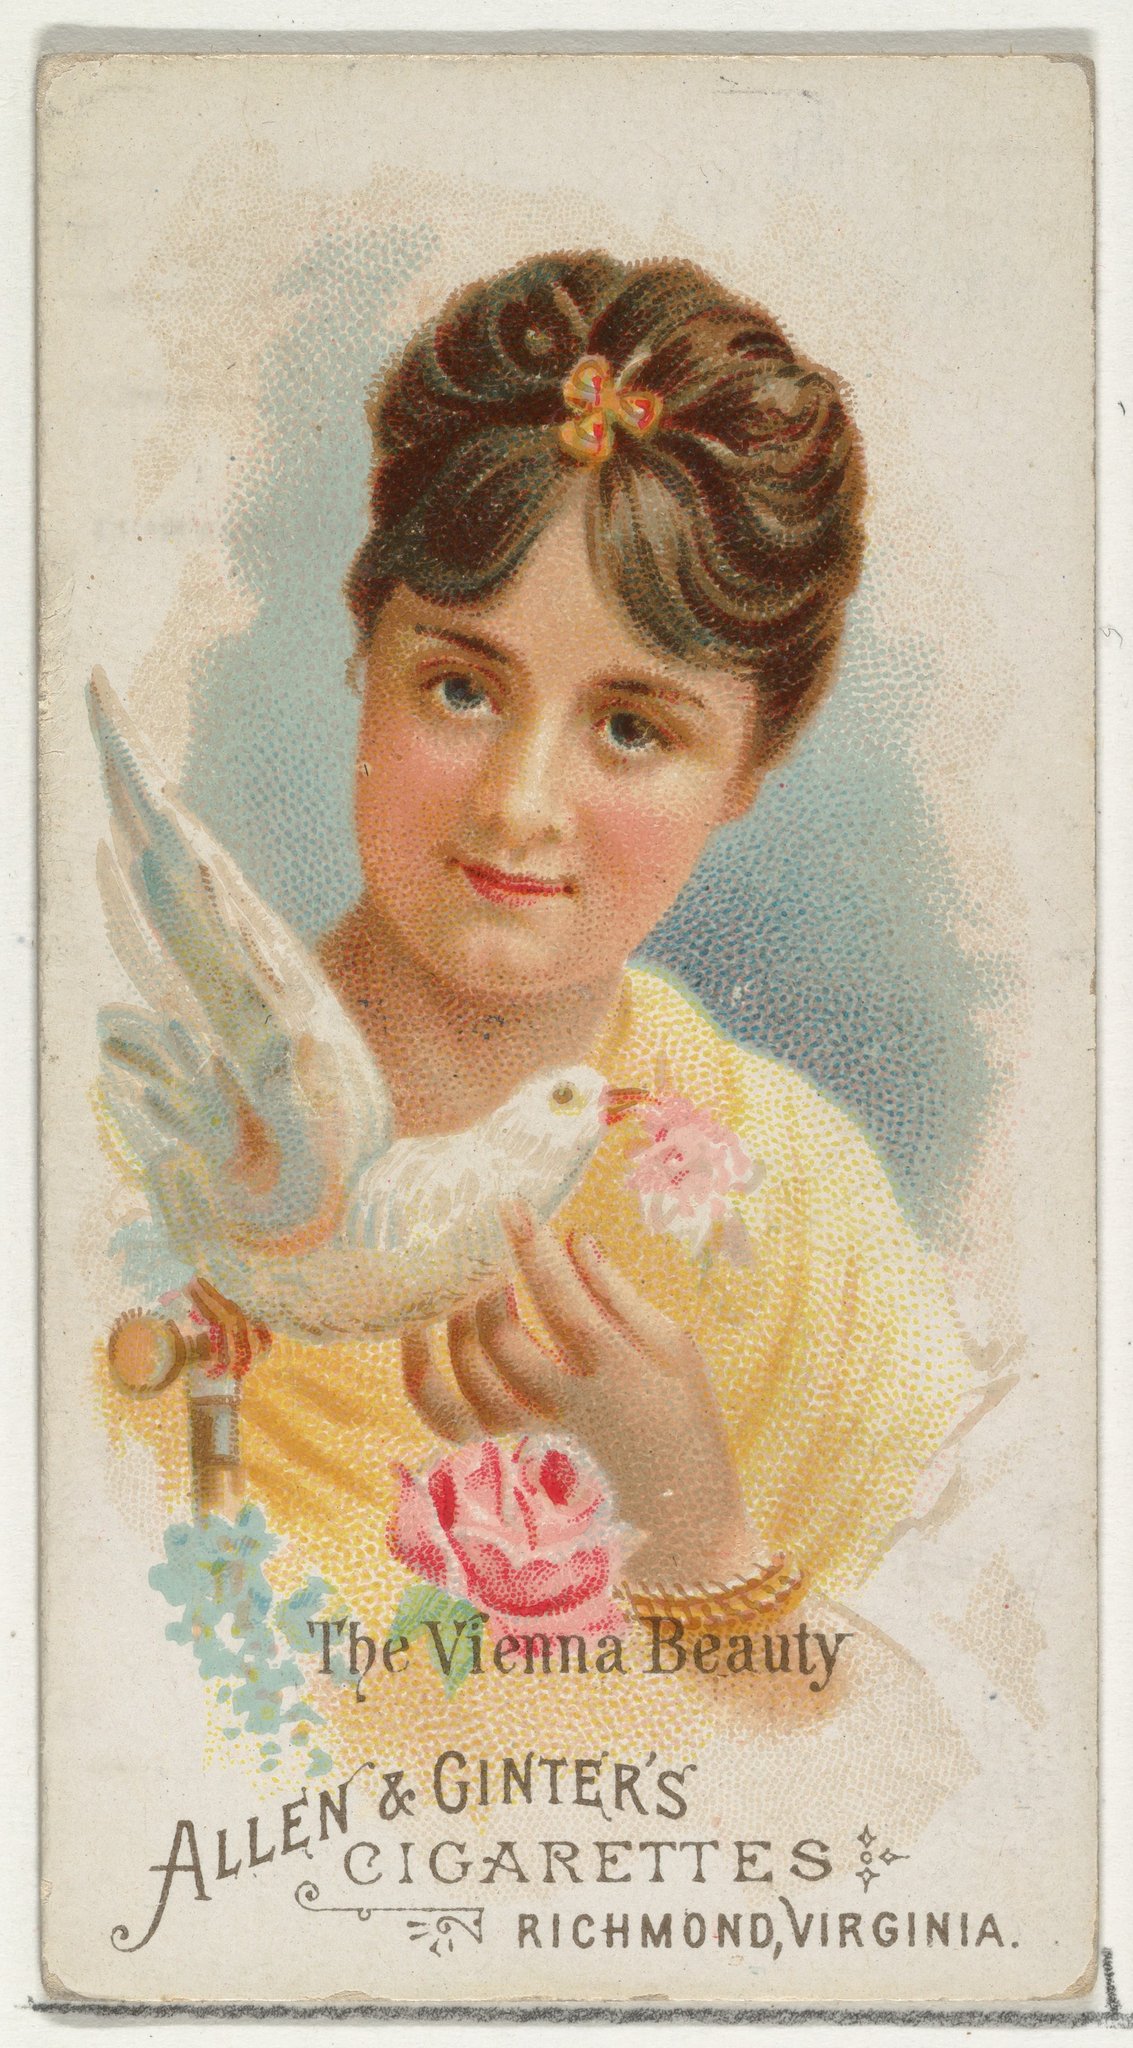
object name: print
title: The Vienna Beauty, from World's Beauties, Series 1 (N26) for Allen & Ginter Cigarettes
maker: allen & ginter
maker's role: publisher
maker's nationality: american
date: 1888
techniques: color lithograph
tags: birds,women